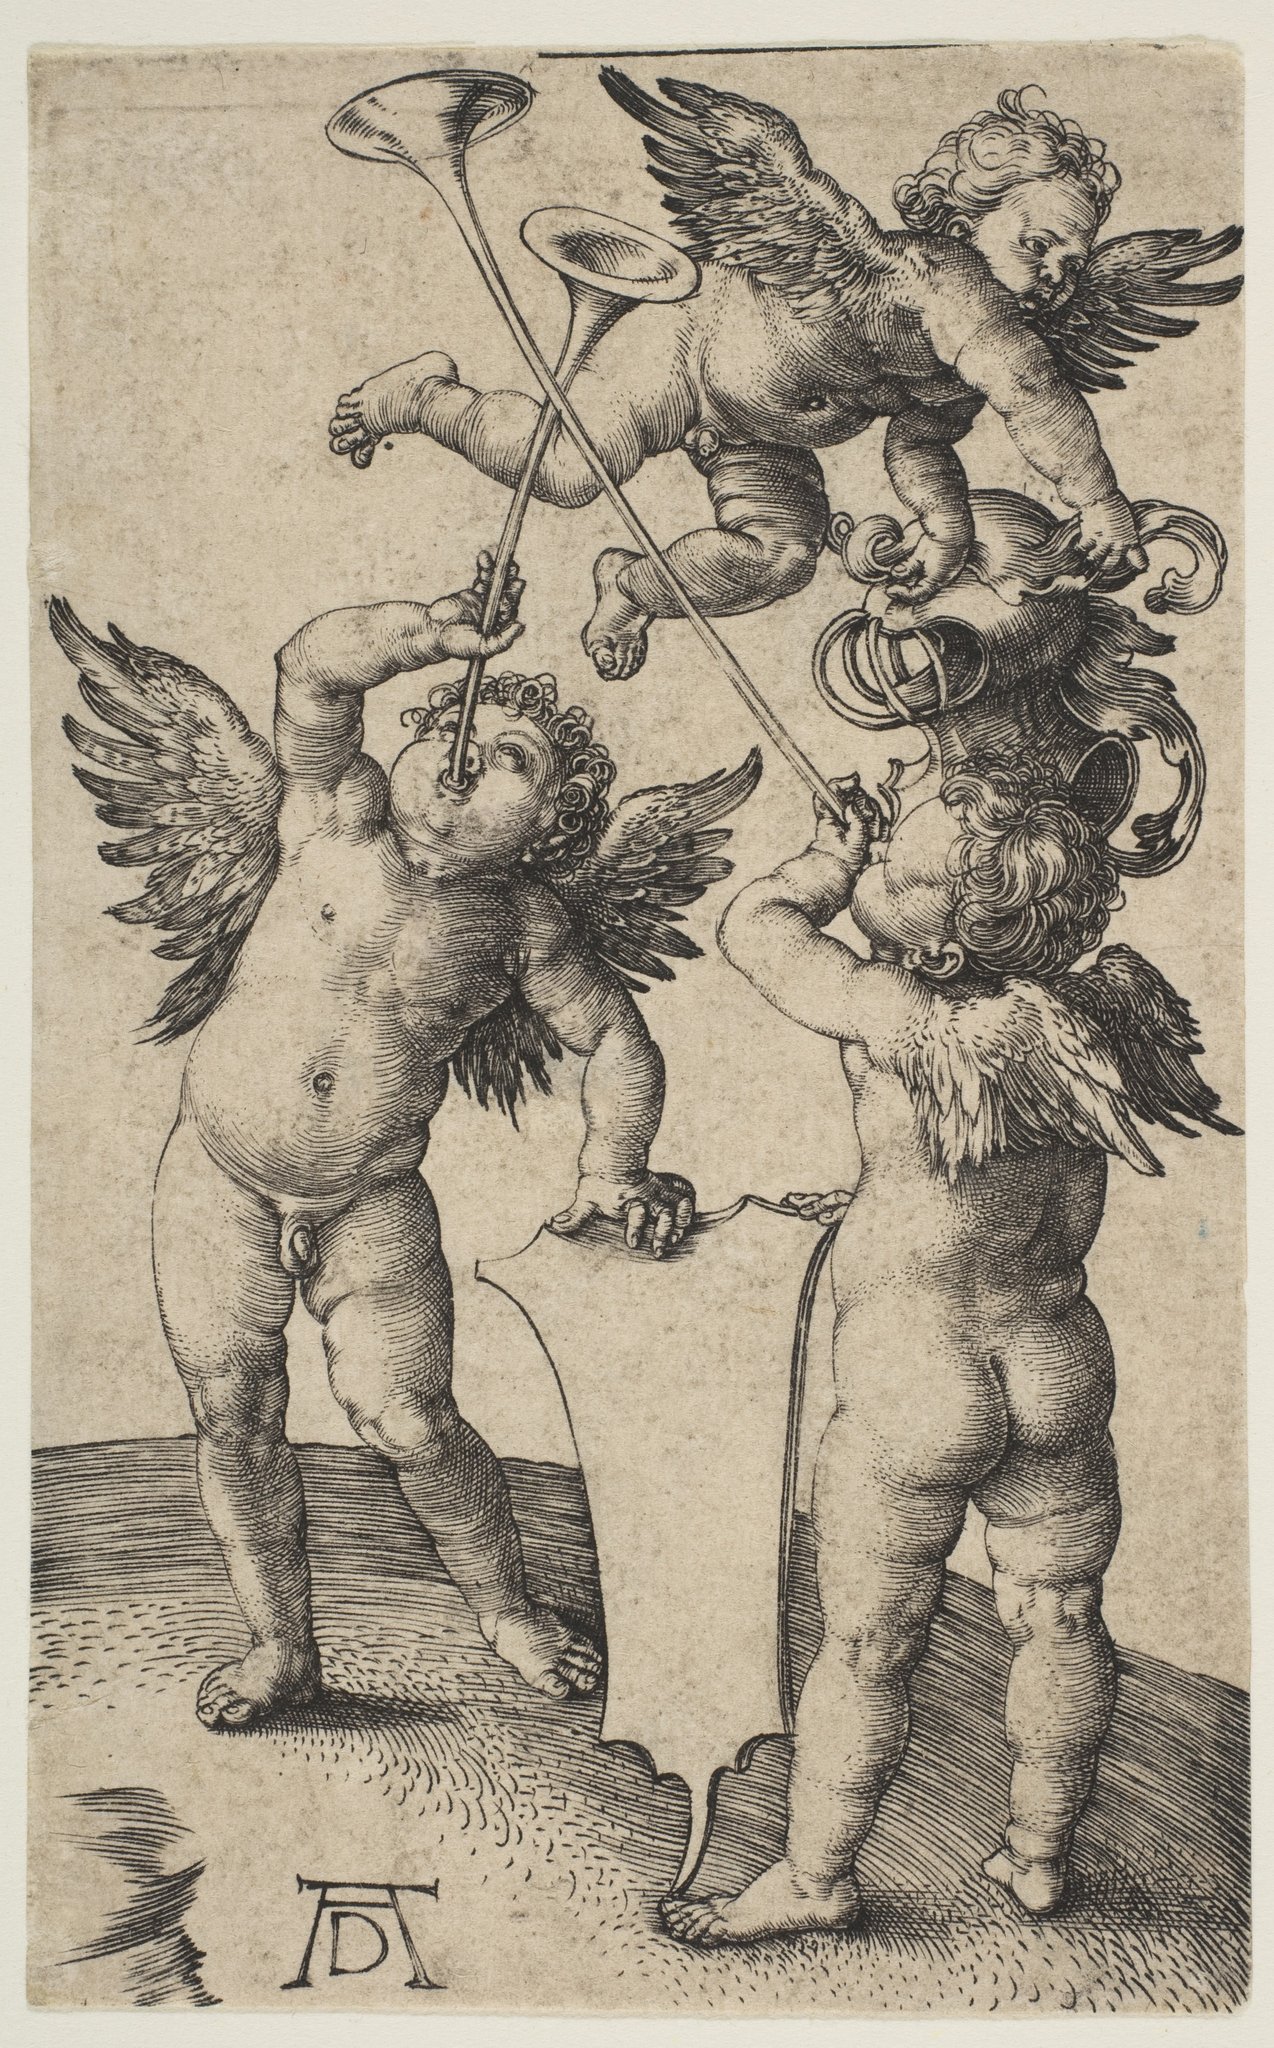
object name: print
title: Three Putti with Trumpets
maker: albrecht dürer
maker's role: artist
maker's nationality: german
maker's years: 1471-1528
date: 1500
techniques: engraving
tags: music,trumpets